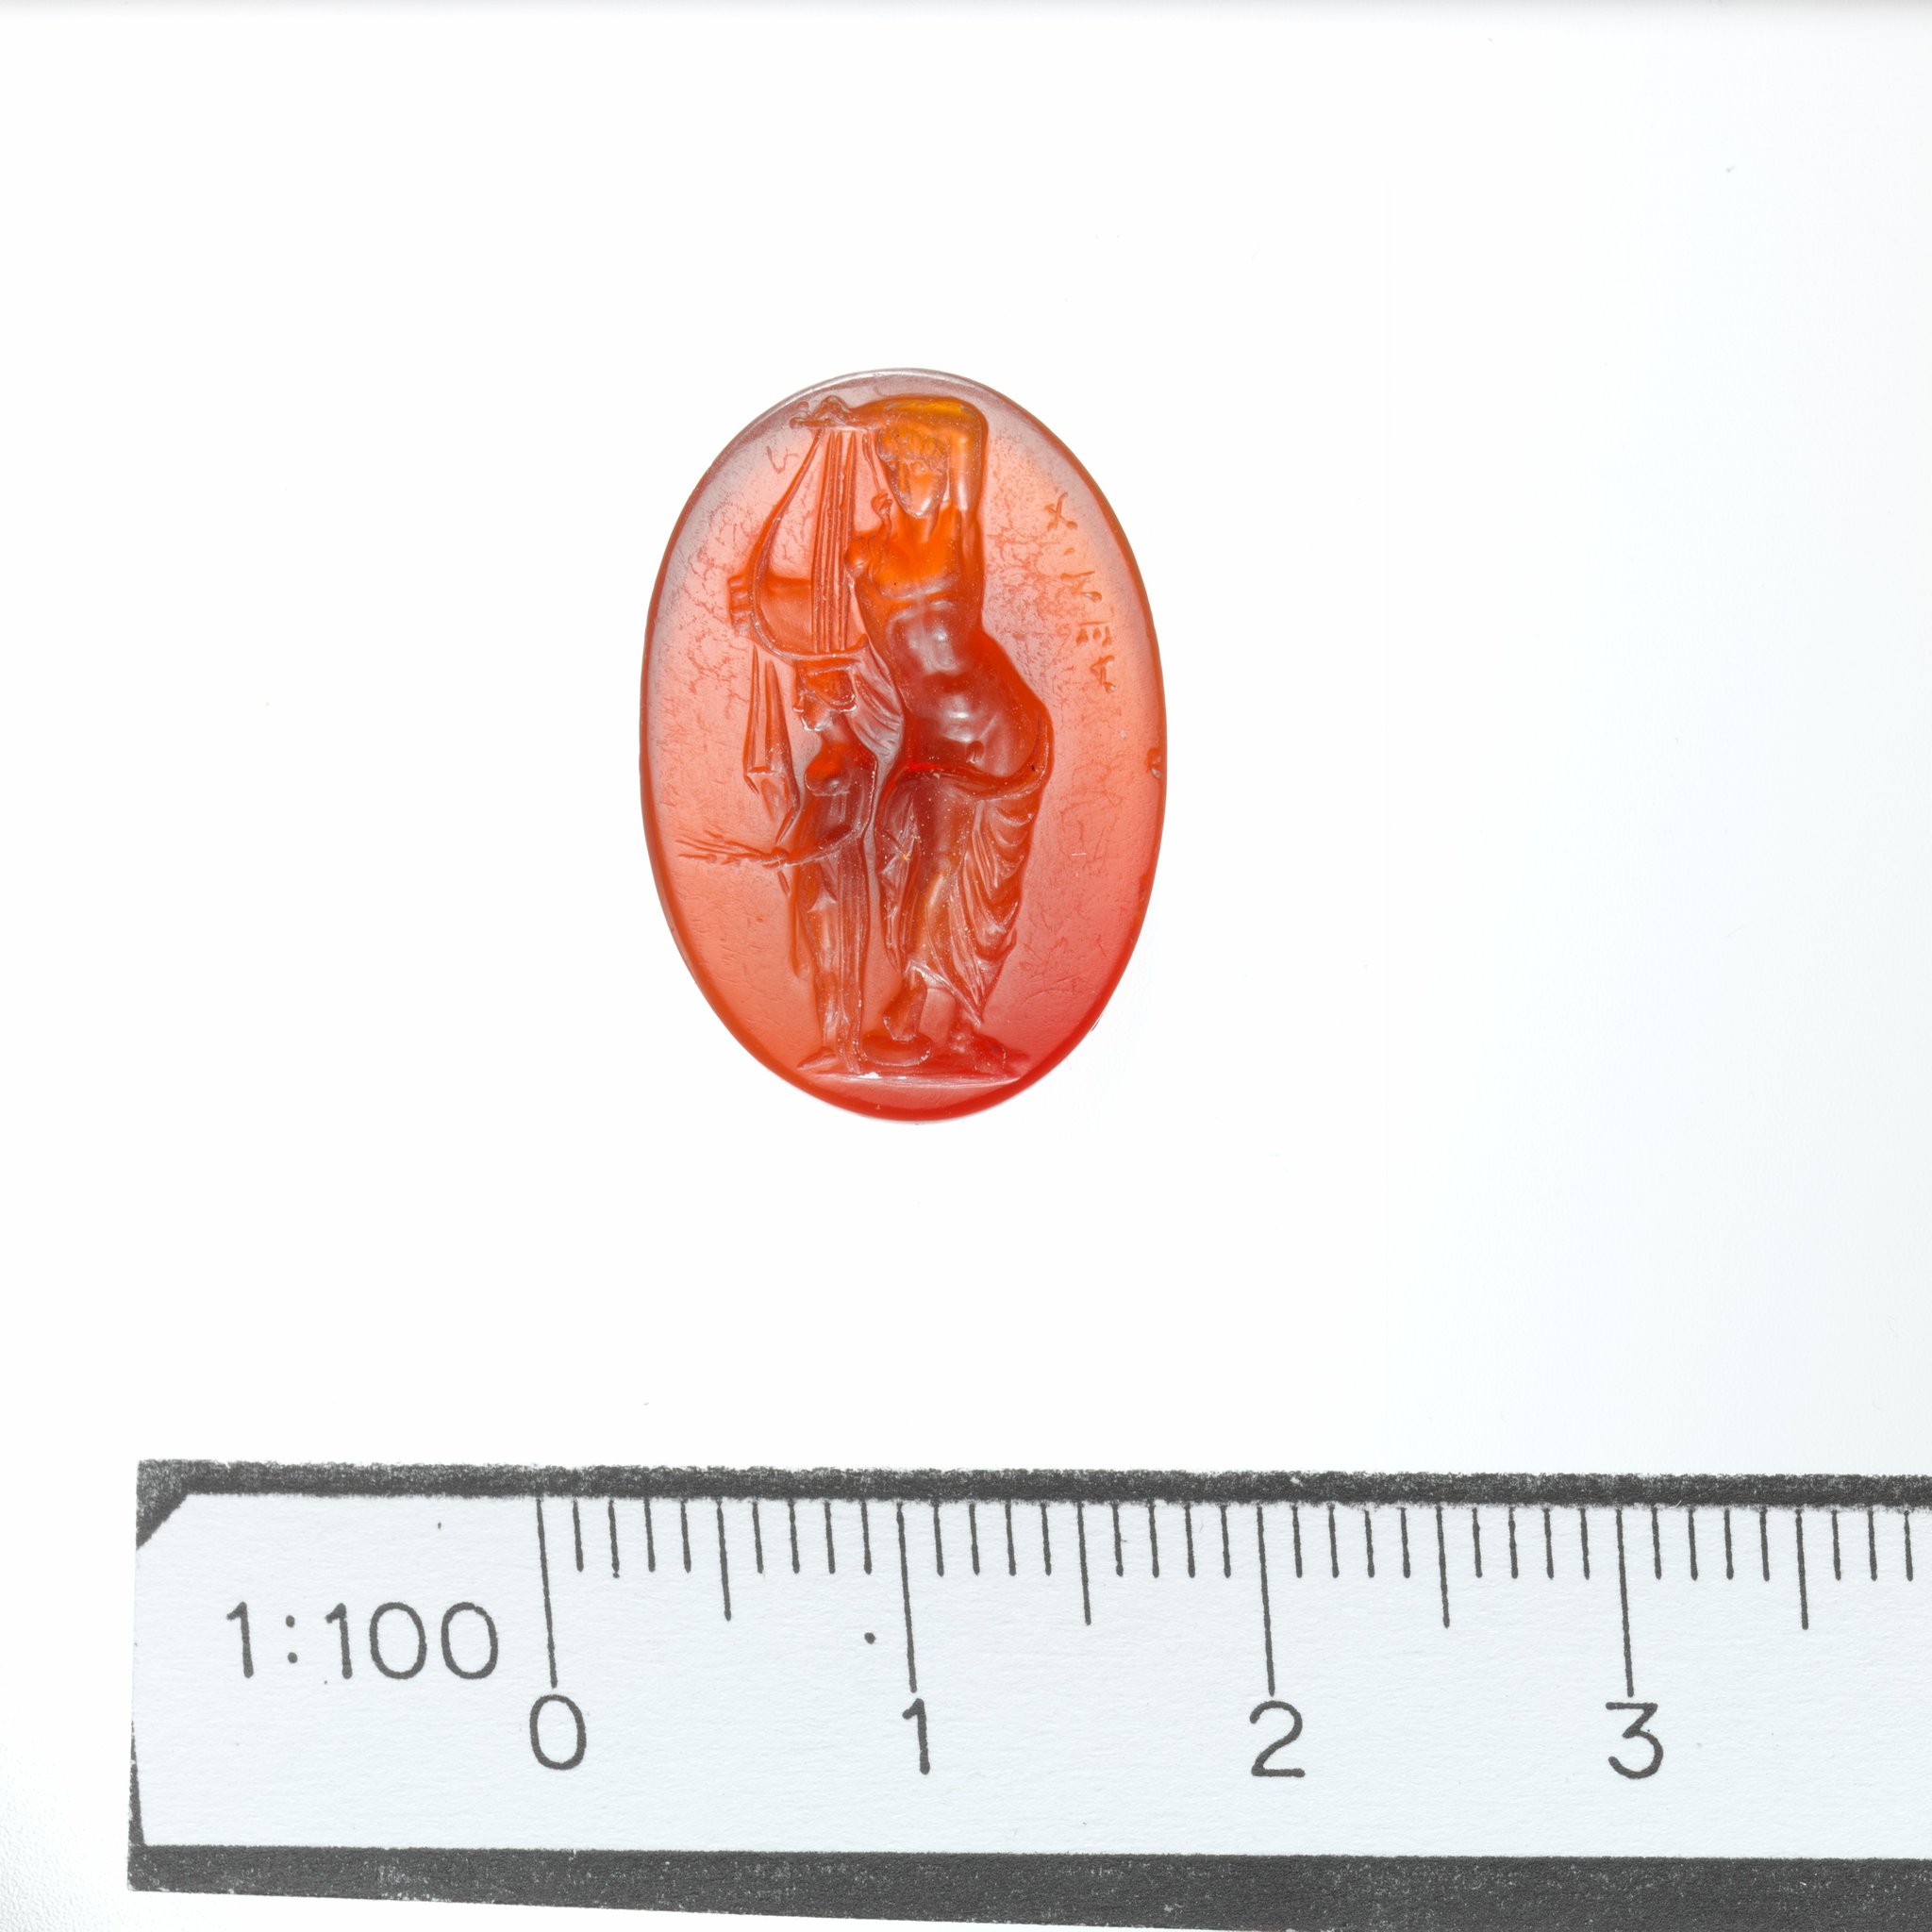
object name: intaglio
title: Carnelian ring stone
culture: roman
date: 100 BCE-300 CE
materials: gemstone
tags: women,apollo